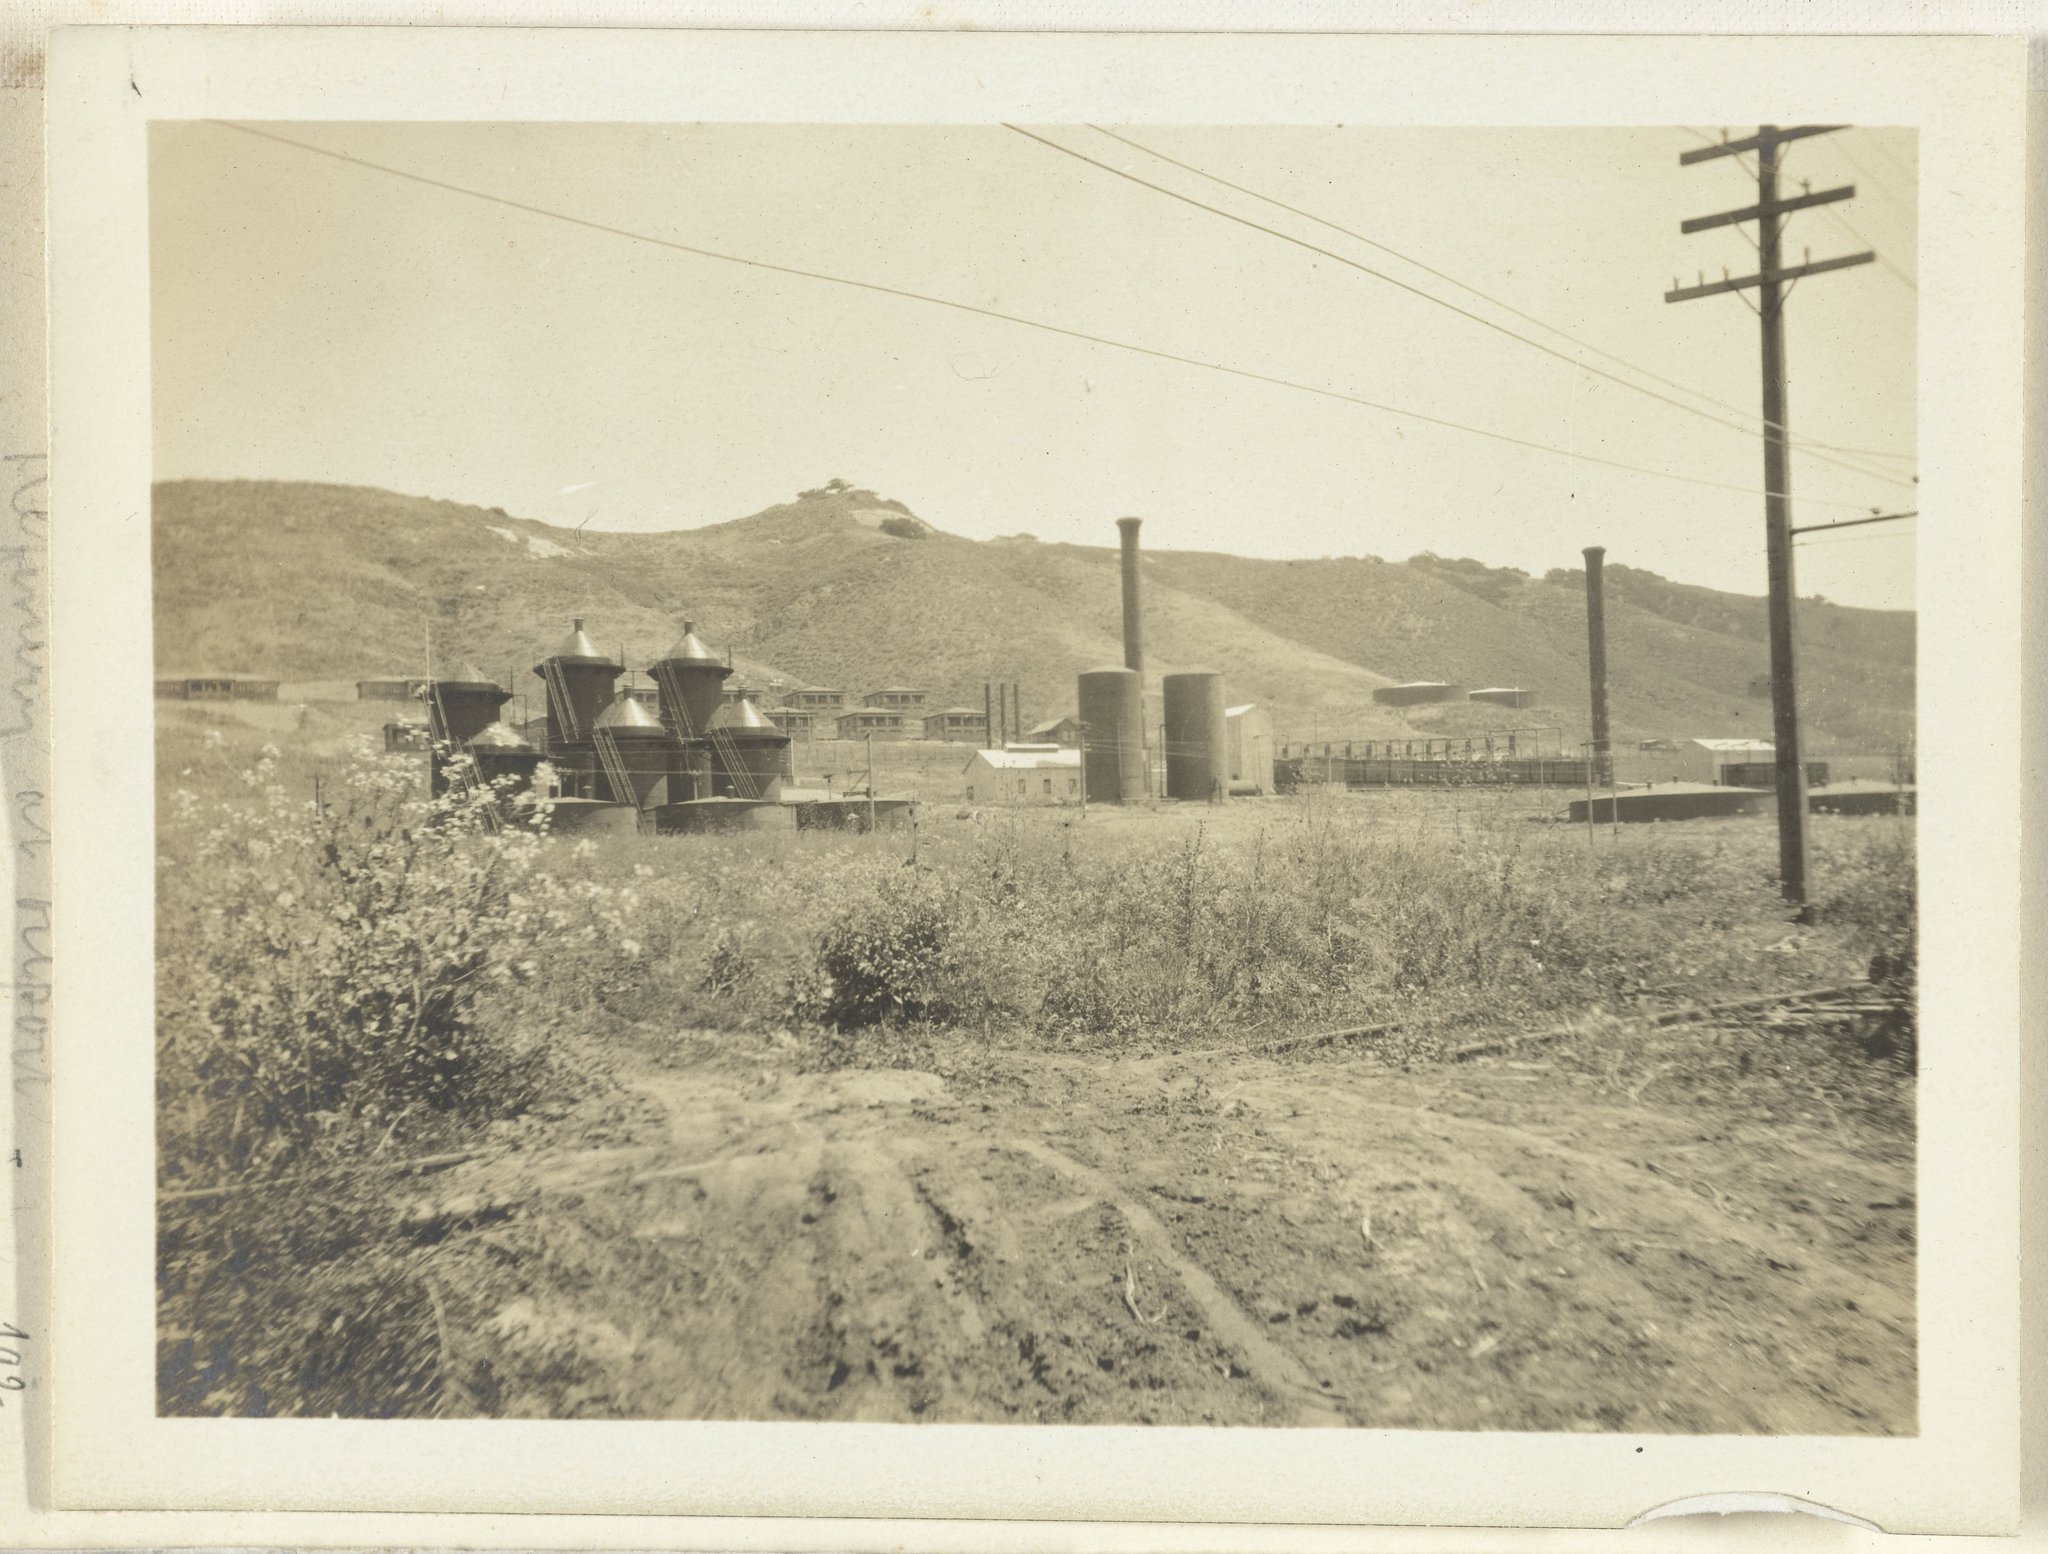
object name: photograph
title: Visit to an Oil Field in Purissima Hills, USA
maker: geldolph adriaan kessler (dolph)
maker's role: fotograaf, industrieel, voetballer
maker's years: 1884-1945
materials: cardboard, photographic support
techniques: gelatin silver print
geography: california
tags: united states of america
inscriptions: title: ‘Refinery at Oil port’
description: In 1908 Kessler accompanied the director of Koninklijke Olie (Royal Dutch Petroleum Company, later Shell), Henri Deterding, as secretary on a world tour. He travelled to Canada and the United States via the Dutch East Indies, Singapore, China, and Japan. Dolph’s photo album contains pictures of an oil field in California, as well as San Francisco’s town hall which had collapsed during an earthquake.